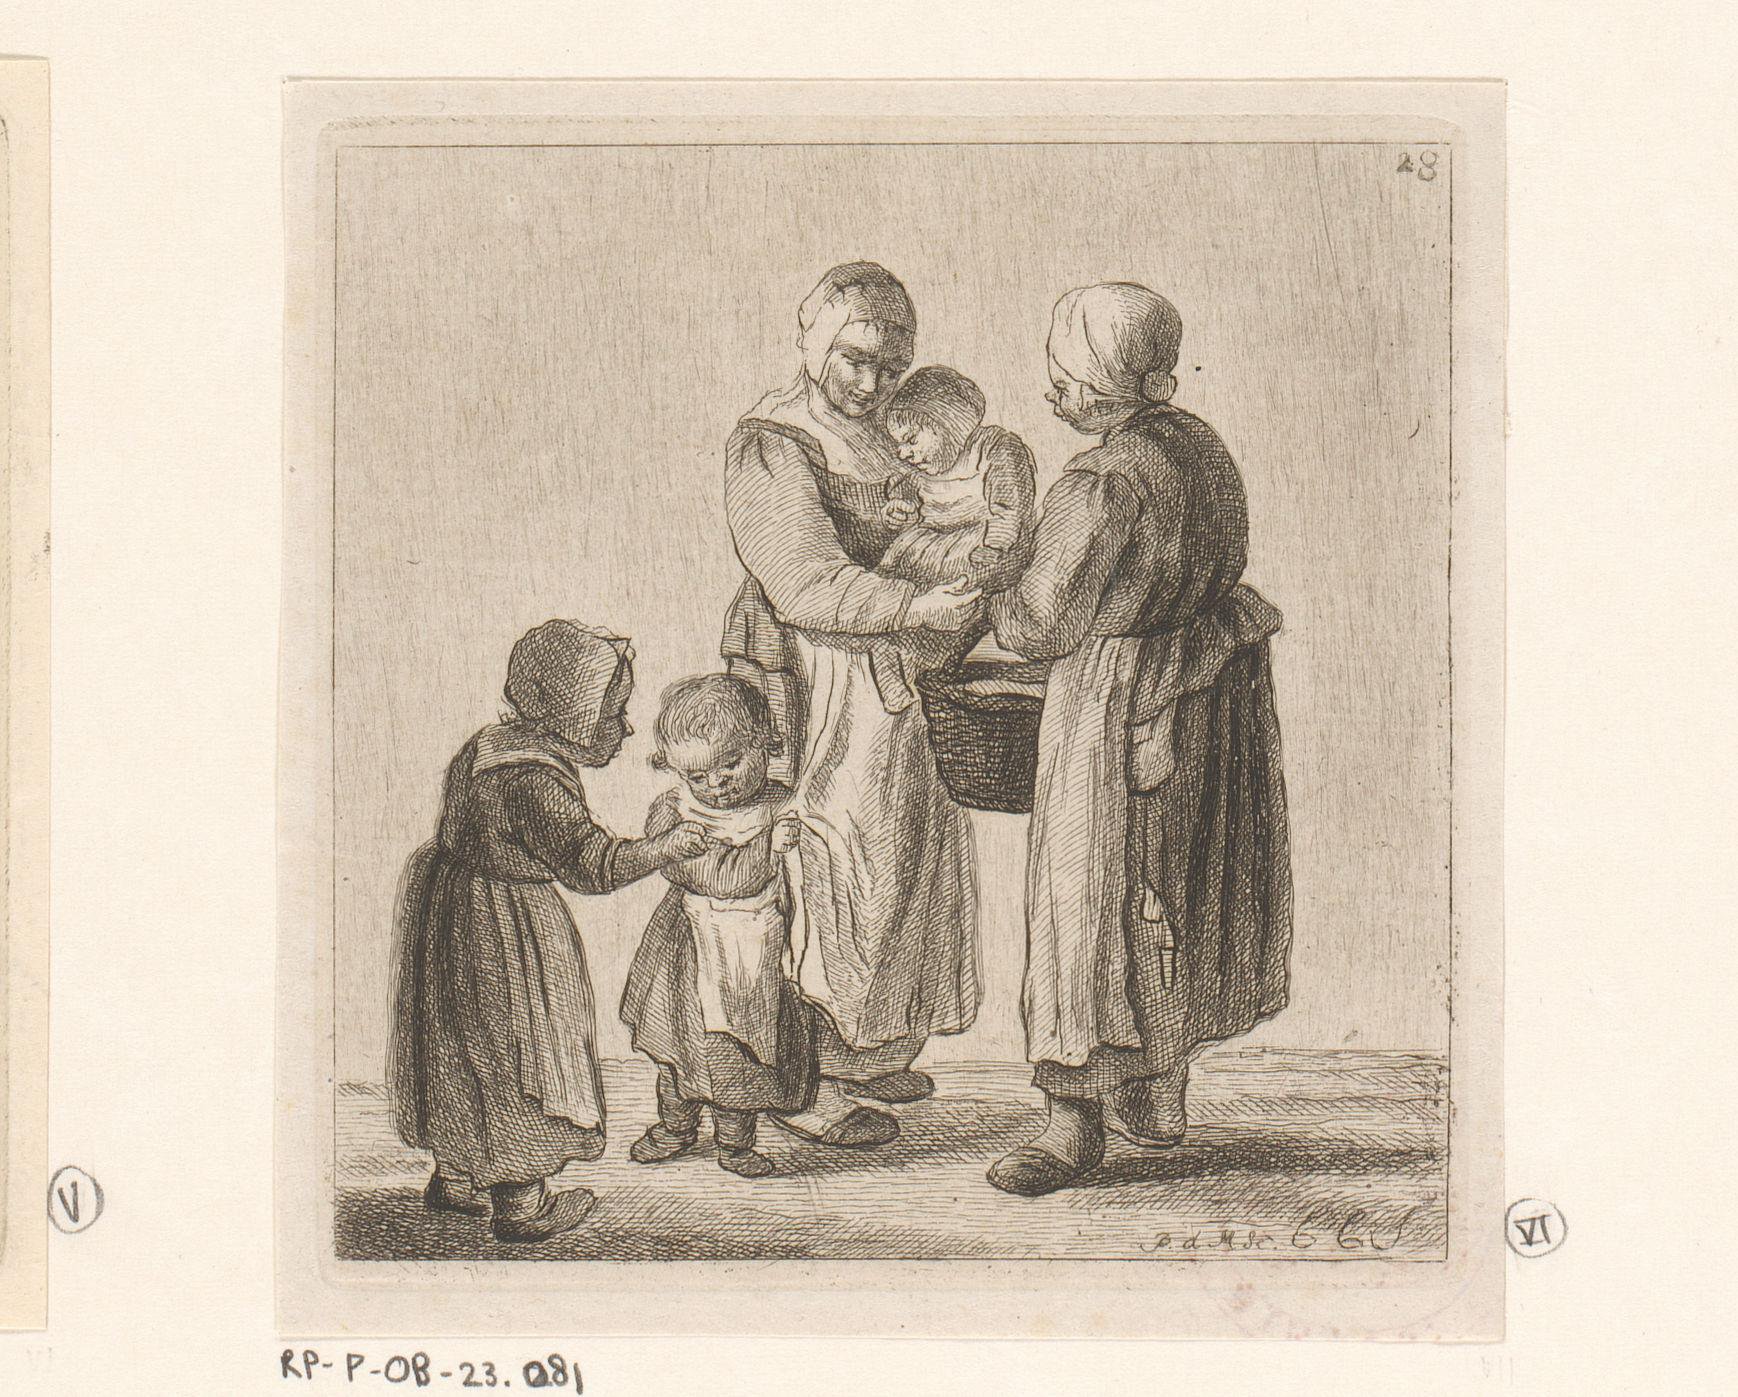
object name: print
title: Twee moeders met kinderen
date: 1779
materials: paper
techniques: engraving, etching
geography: leiden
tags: mother and baby or young child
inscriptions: collector's mark: Lugt 240